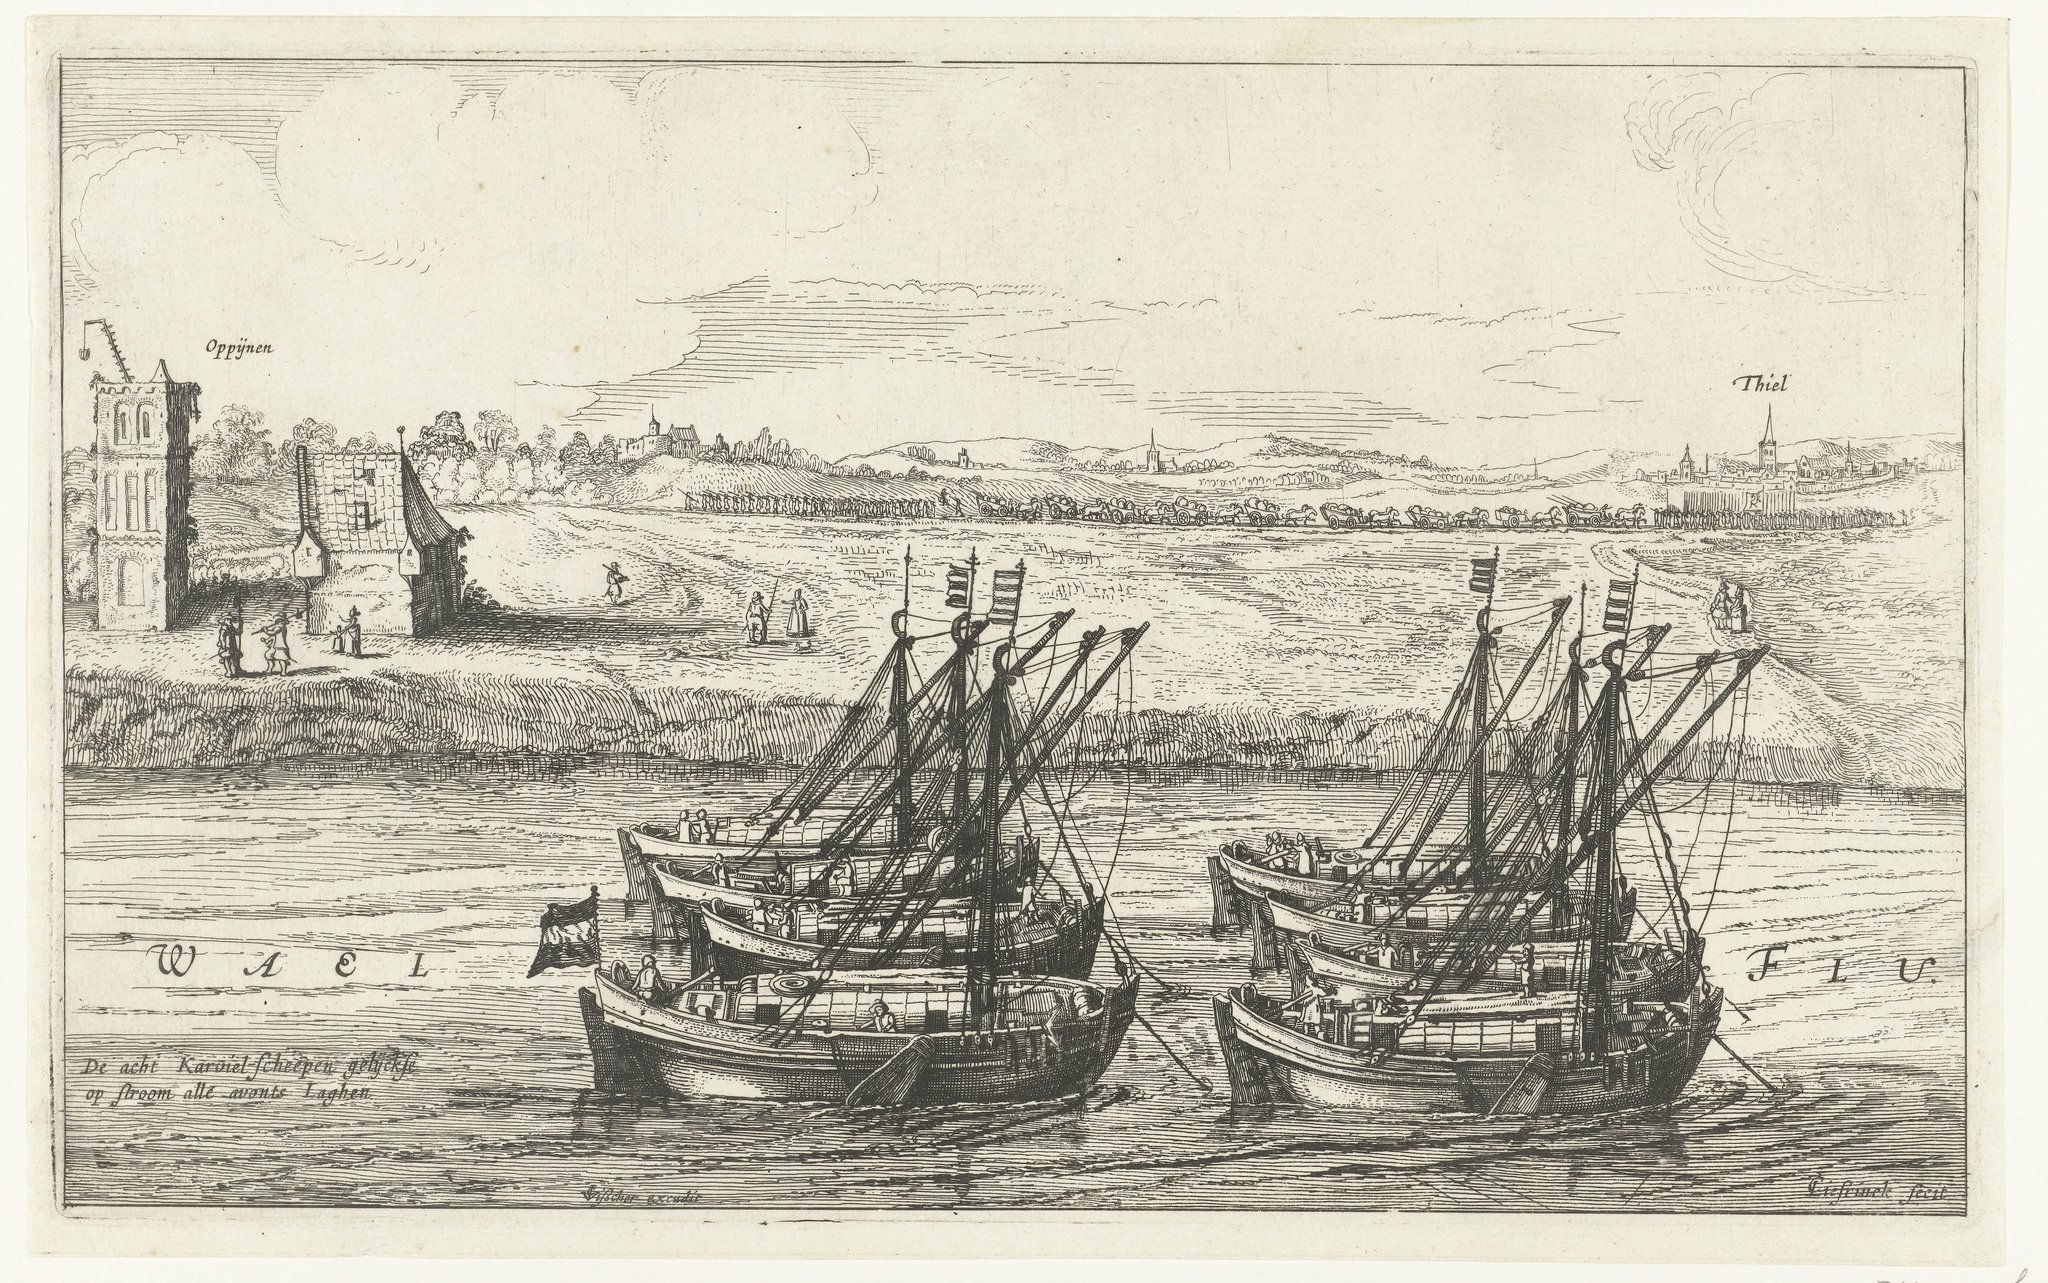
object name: print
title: Tocht van de Leidse Schutterij naar Grave, 1622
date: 1622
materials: paper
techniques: etching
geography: amsterdam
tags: the hague, maurice (prince of orange), troop movements, transportation, grave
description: De acht schepen waarin de schutterij de tocht naar Grave heeft gemaakt, liggend voor anker in de Waal, 26 september 1622. Onderdeel van een serie van 3 prenten van de tocht van de schutterij van Leiden naar Grave om de stad bezet te houden zodat Maurits ter ontzet naar Bergen op Zoom op kan trekken. Zonder de verzen onder de plaat.